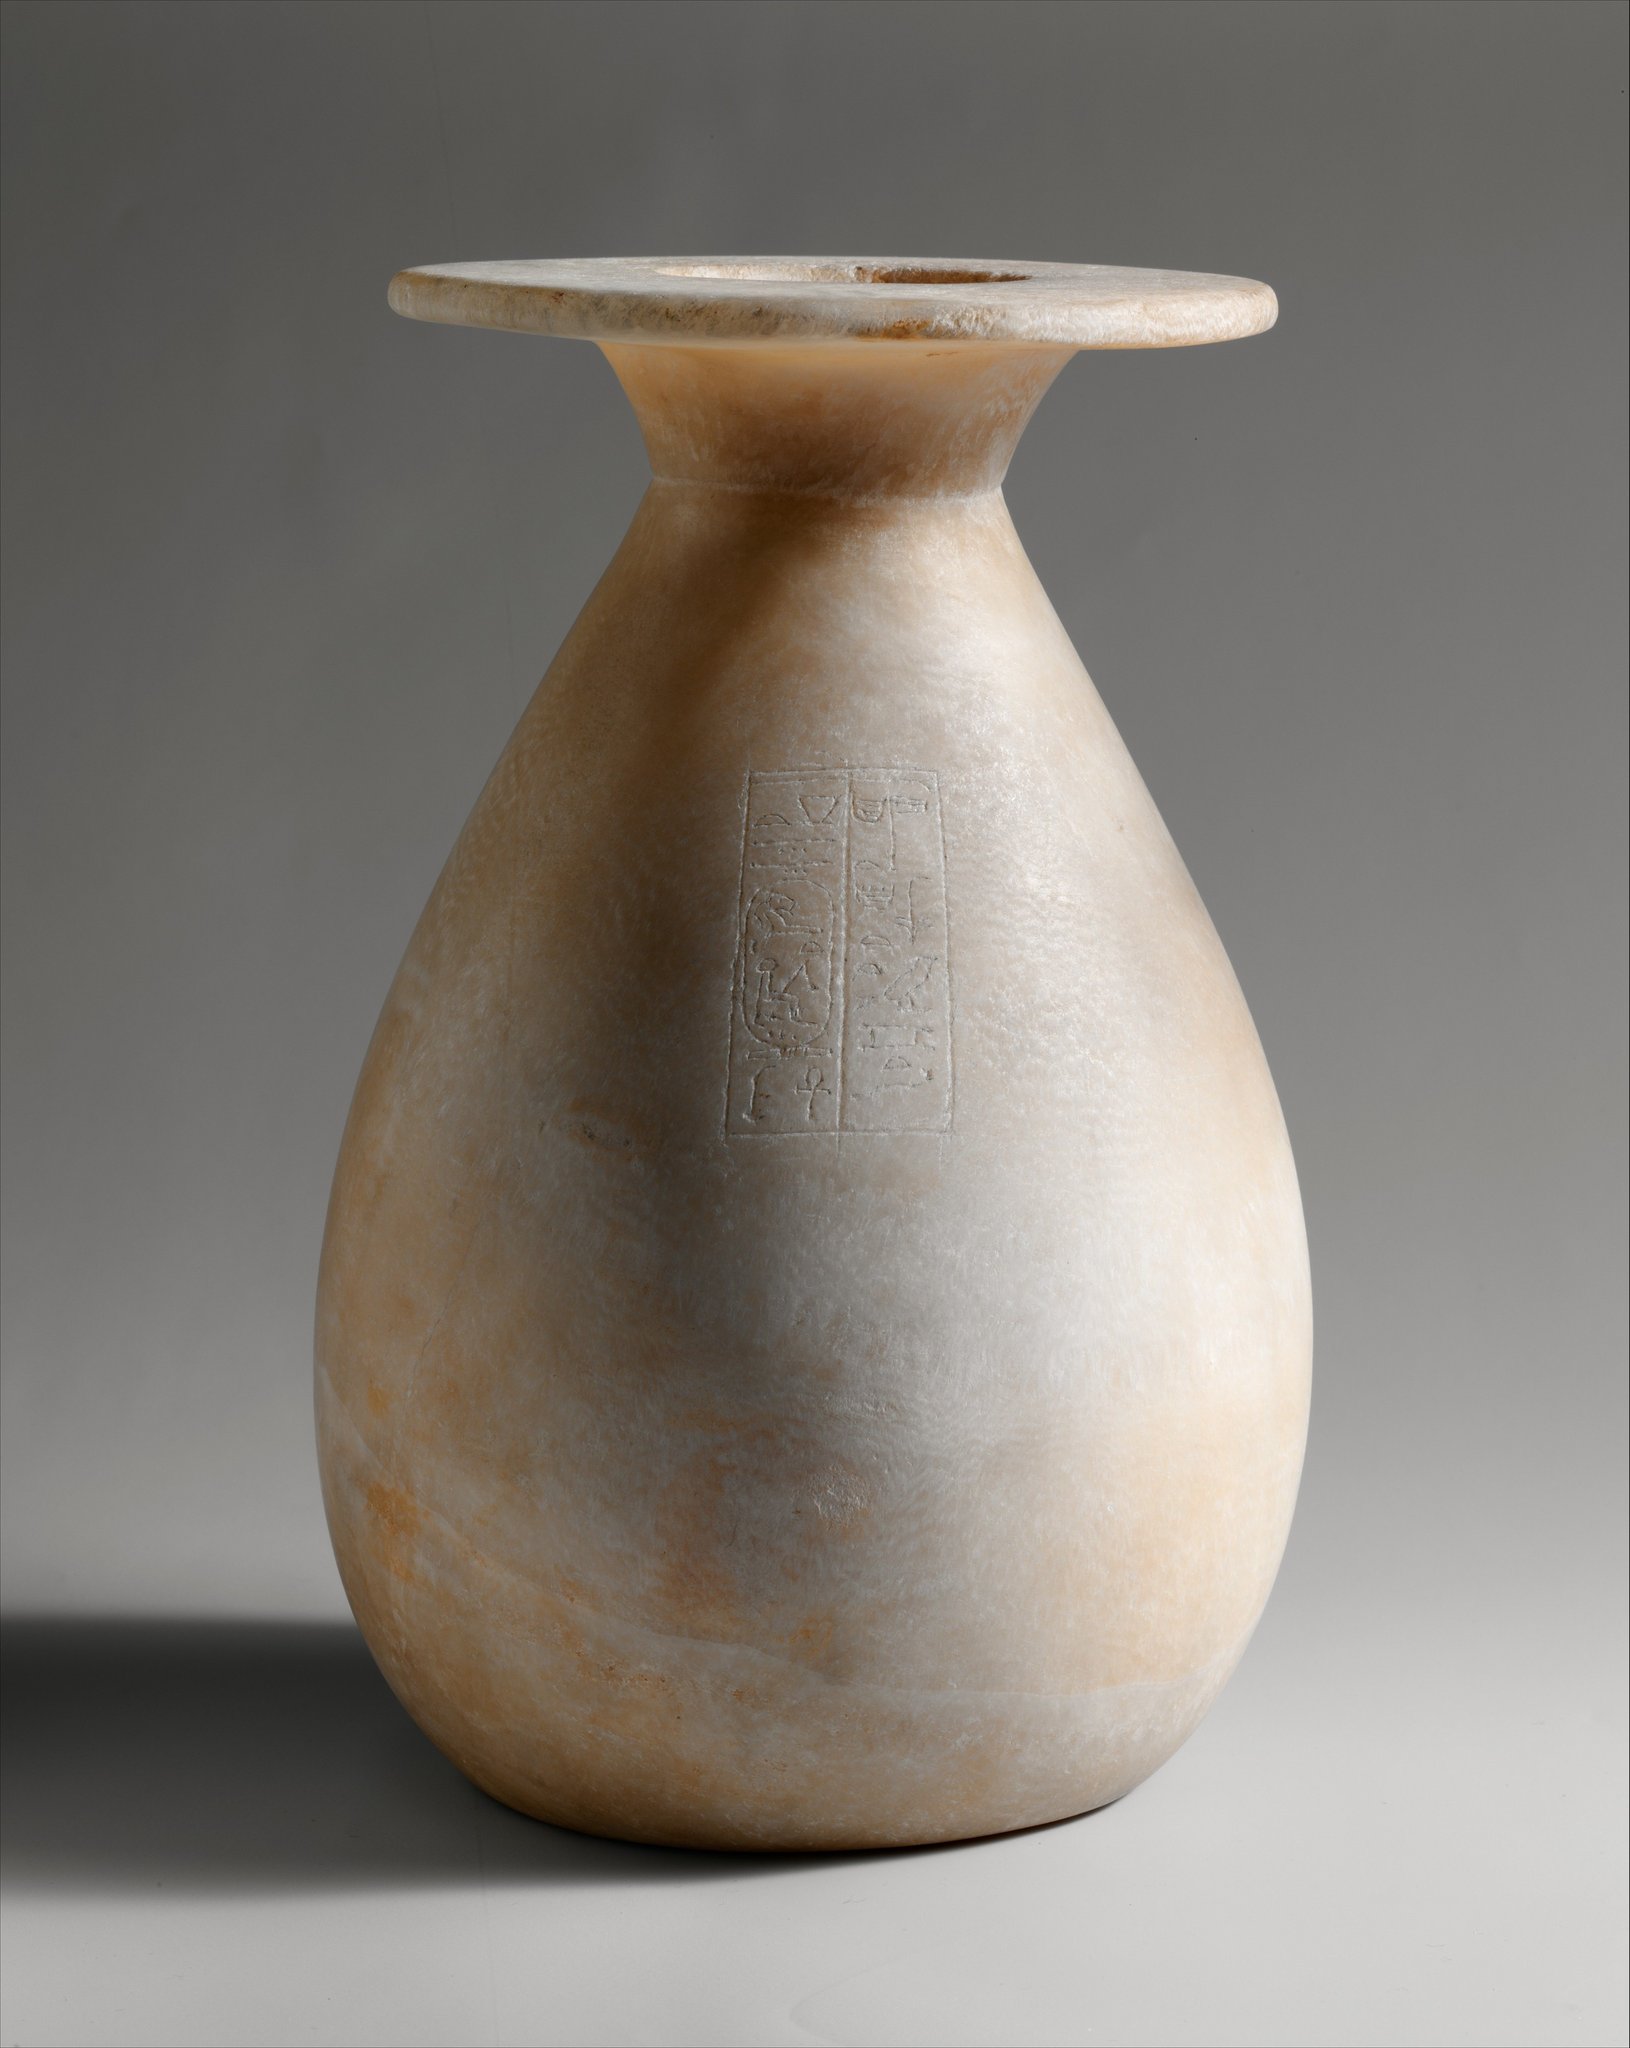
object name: jar, piriform, hatshepsut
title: Piriform Jar Inscribed with Hatshepsut's Titles as Queen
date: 1492-1473 BCE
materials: stone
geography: upper egypt, thebes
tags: hieroglyphs